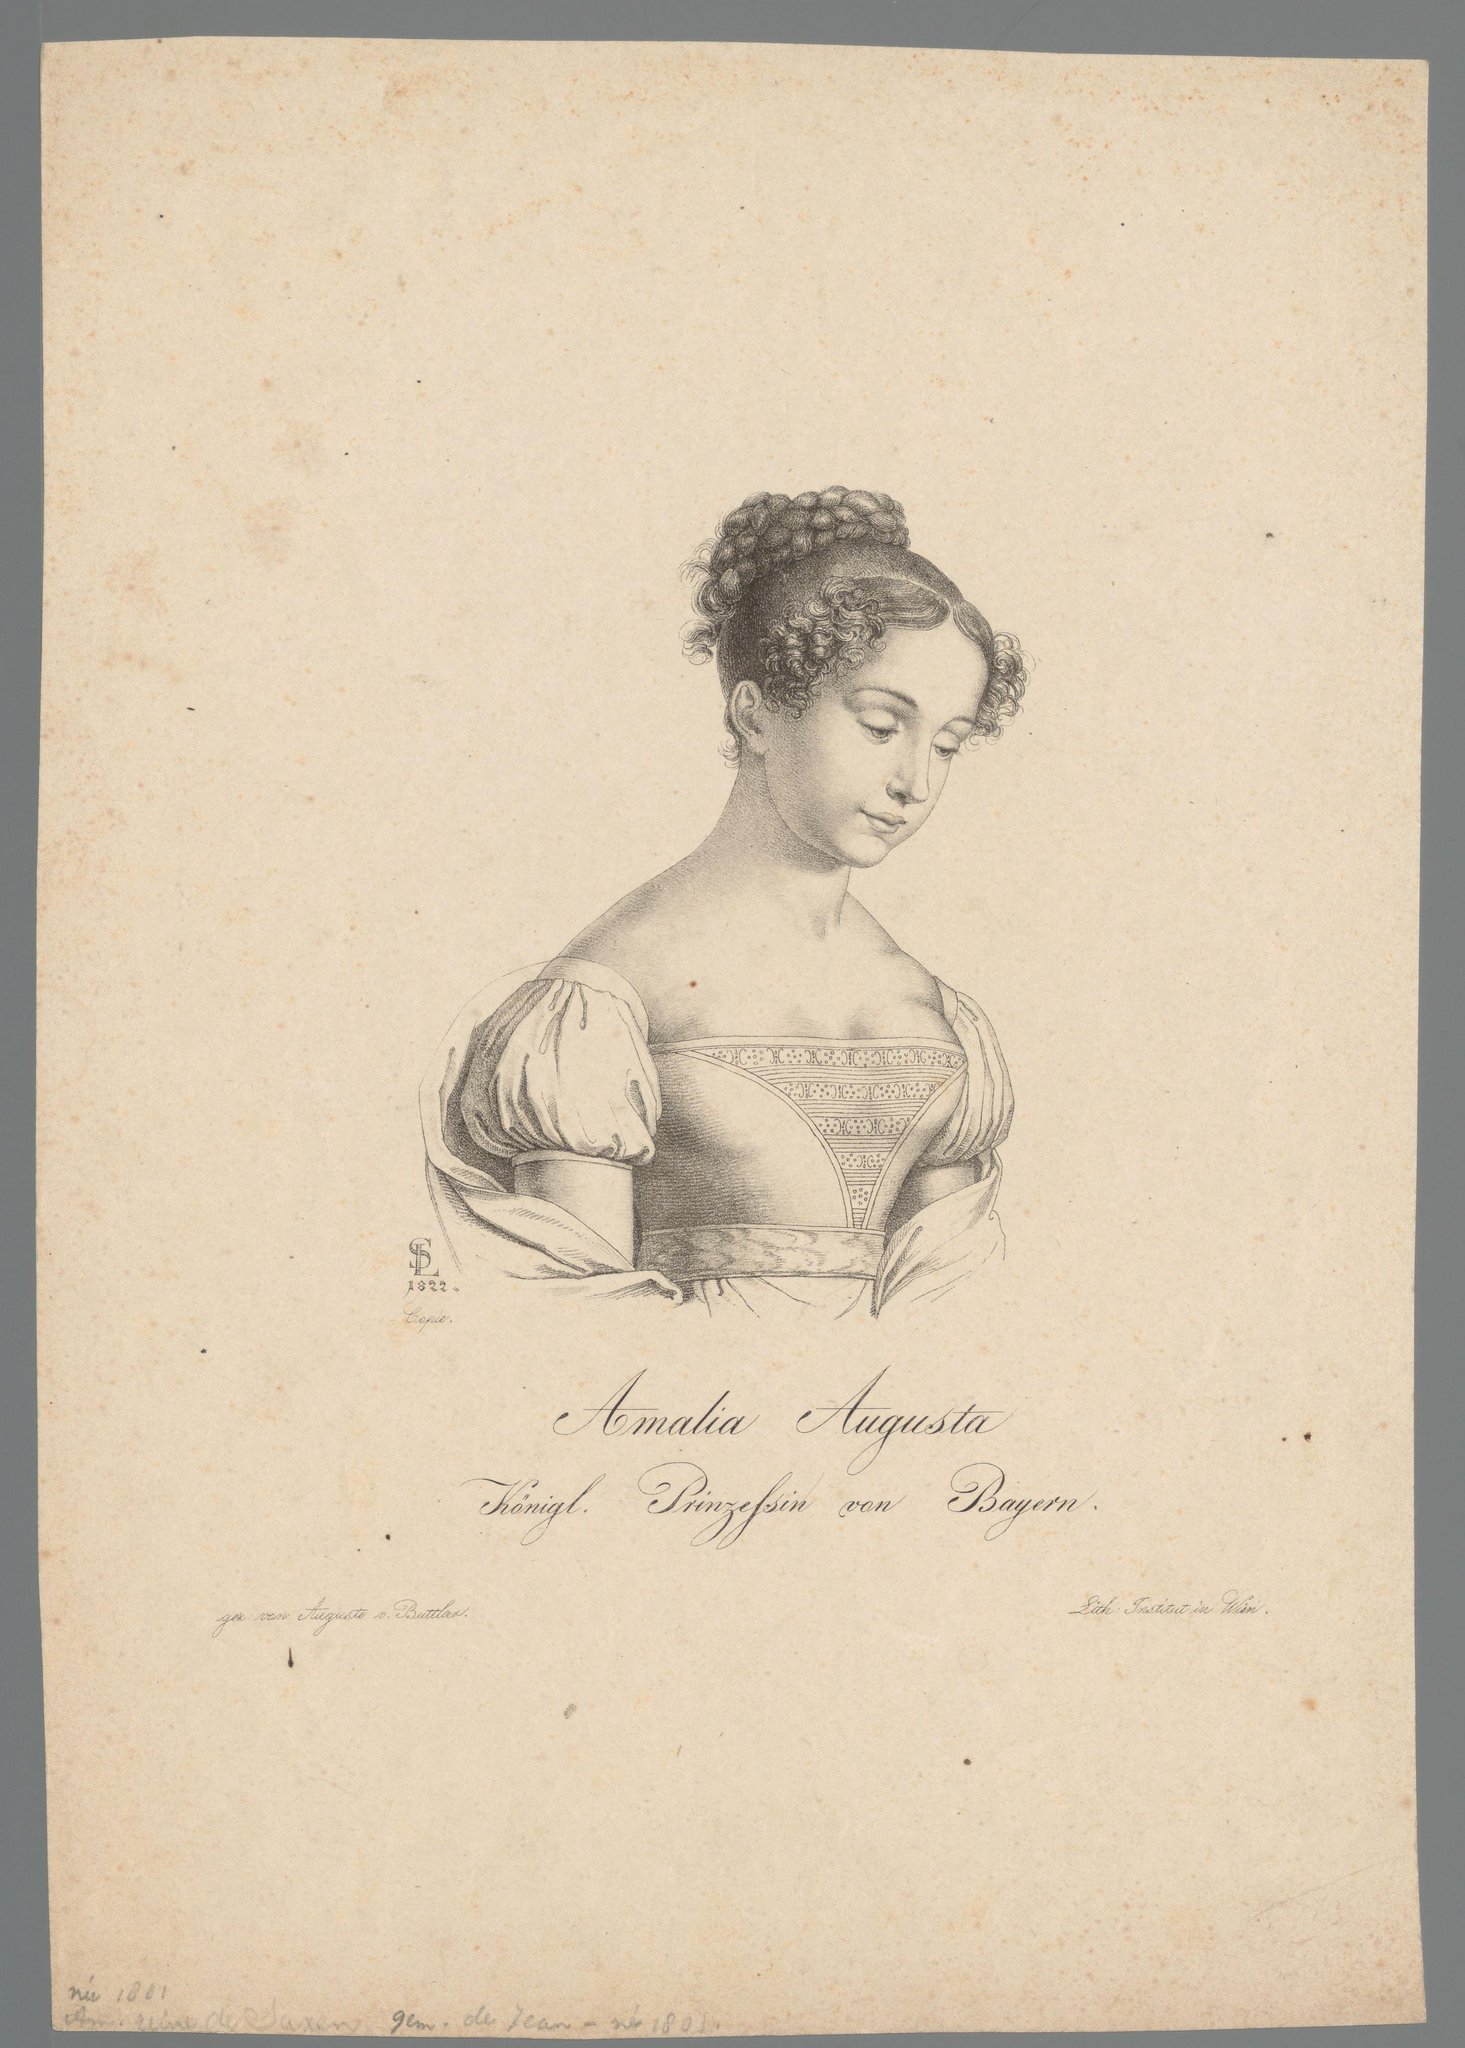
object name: print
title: Portret van Amalia Augusta van Beieren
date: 1822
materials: paper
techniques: lithograph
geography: vienna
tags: historical persons, queen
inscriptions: collector's mark: Lugt 2228